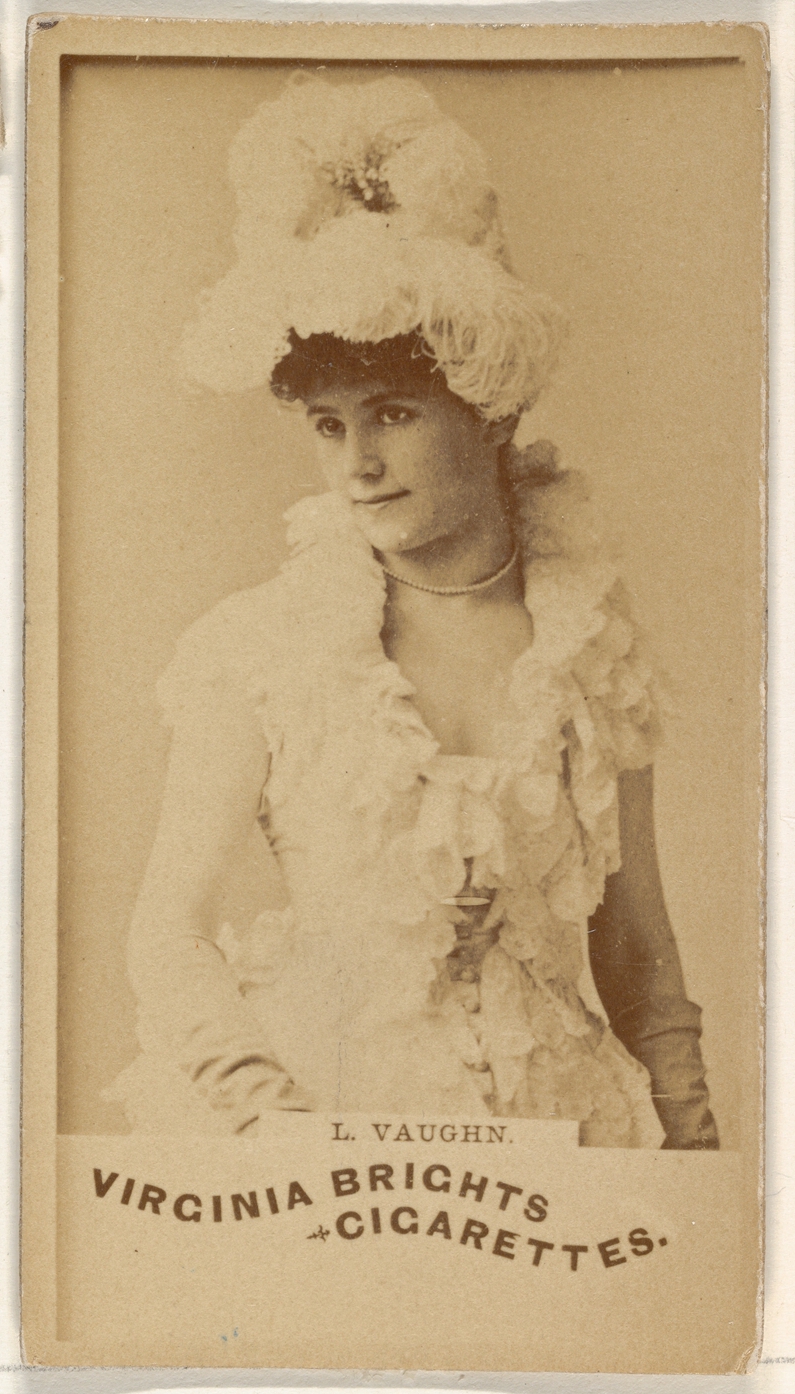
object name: photograph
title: L. Vaughn, from the Actors and Actresses series (N45, Type 1) for Virginia Brights Cigarettes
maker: allen & ginter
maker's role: publisher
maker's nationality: american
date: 1888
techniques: albumen silver print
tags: portraits,women,actresses